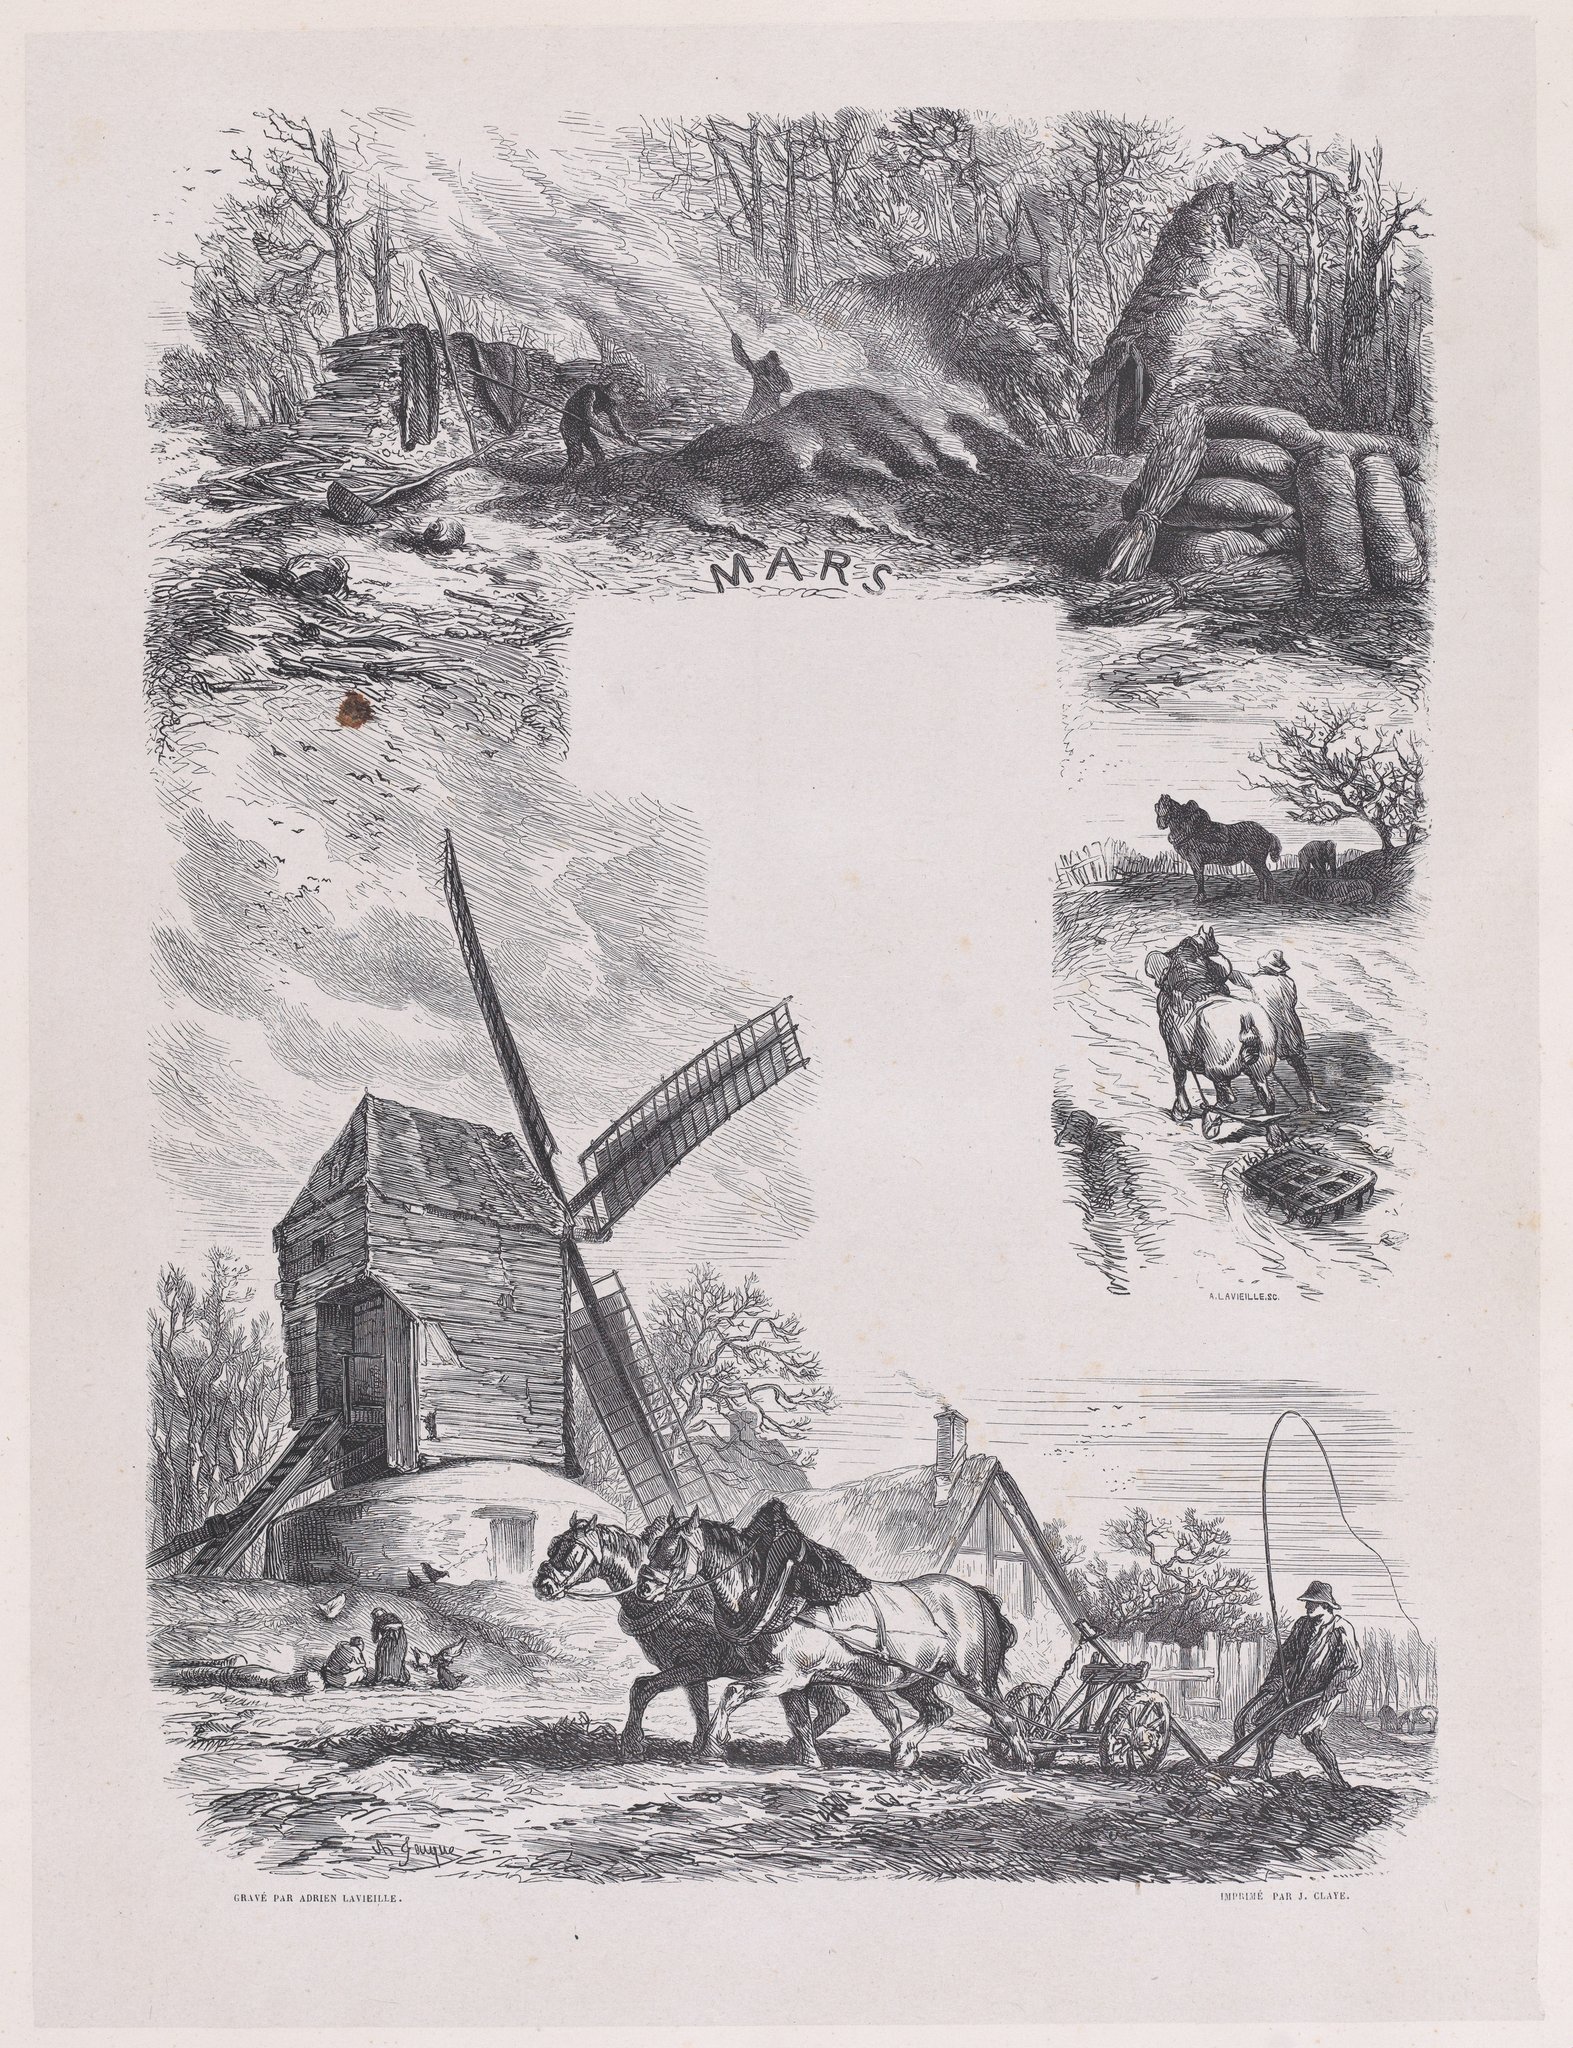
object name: print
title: March, from "Album of Rustic Subjects"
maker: charles émile jacque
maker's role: artist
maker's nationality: french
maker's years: 1813-1894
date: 1859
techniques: engraving